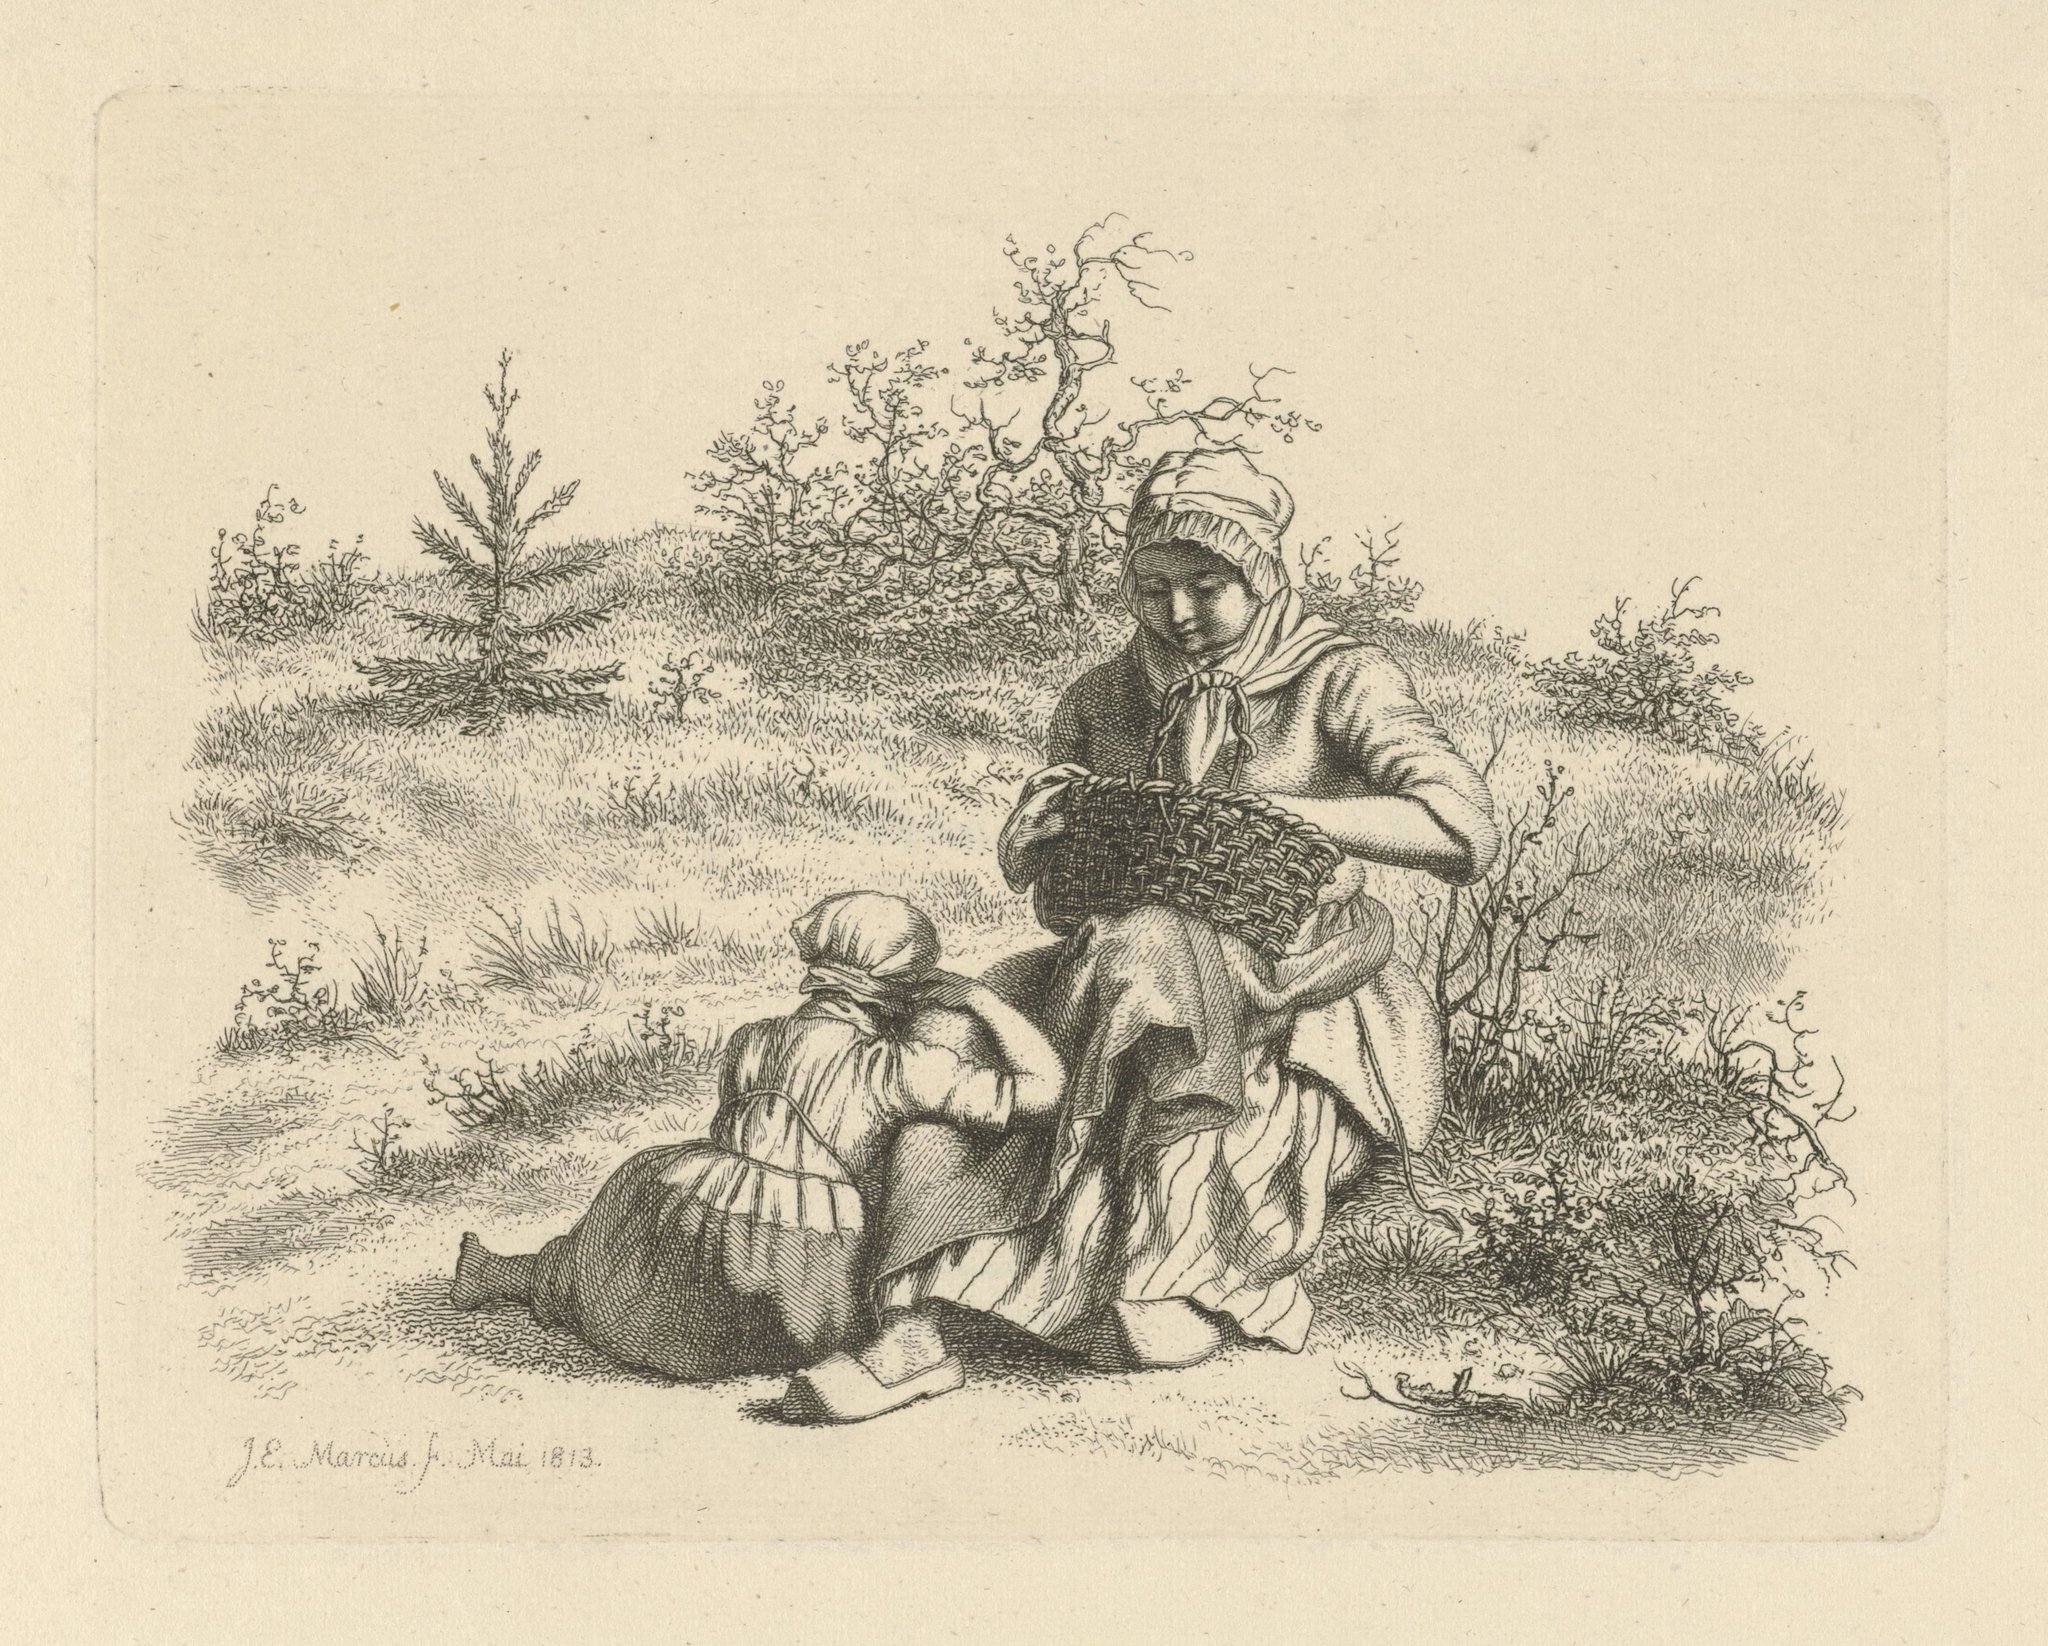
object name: print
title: Zittende vrouw en een meisje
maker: jacob ernst marcus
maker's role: draughtsman, print maker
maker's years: 1774-1826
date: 1805-1813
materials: paper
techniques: etching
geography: amsterdam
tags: girl (child between toddler and youth) (+ sitting), container made of plant material other than wood: basket, sitting on the ground - aa - female human figure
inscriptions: collector's mark: Lugt 2228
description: Serie voor het eerst uitgegeven door Jacob Ernst Marcus onder de titel Studiebeelden en Fragmenten. Amsterdam: ca.1816. Later heruitgegeven als: Studie-prentwerk/ Etudes gravées.